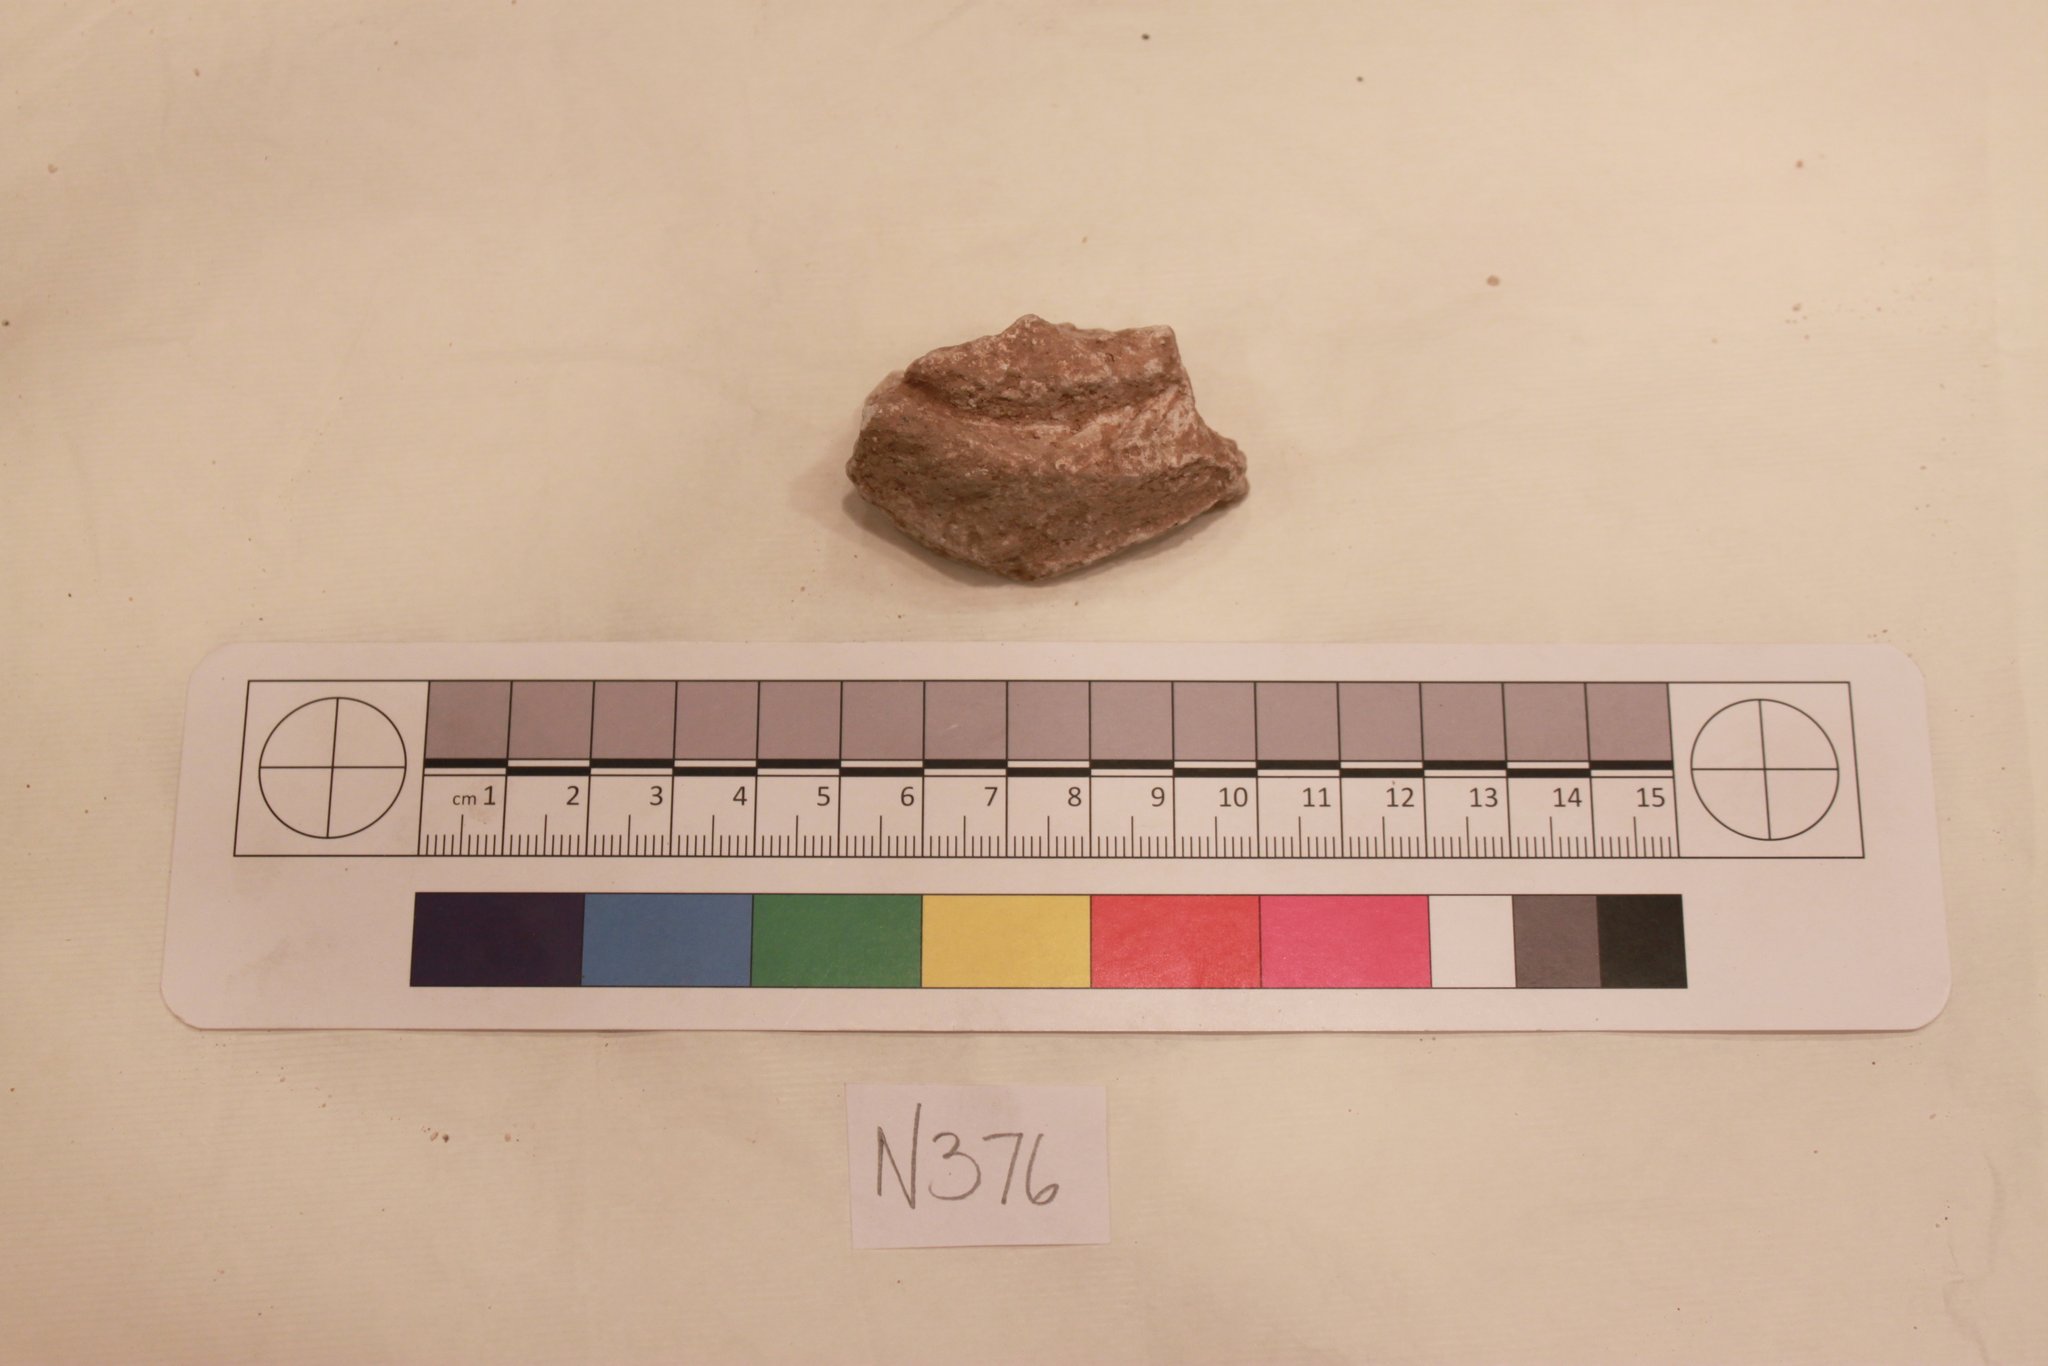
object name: fragment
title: Stucco Fragment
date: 701-1200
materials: plaster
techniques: carving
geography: iran